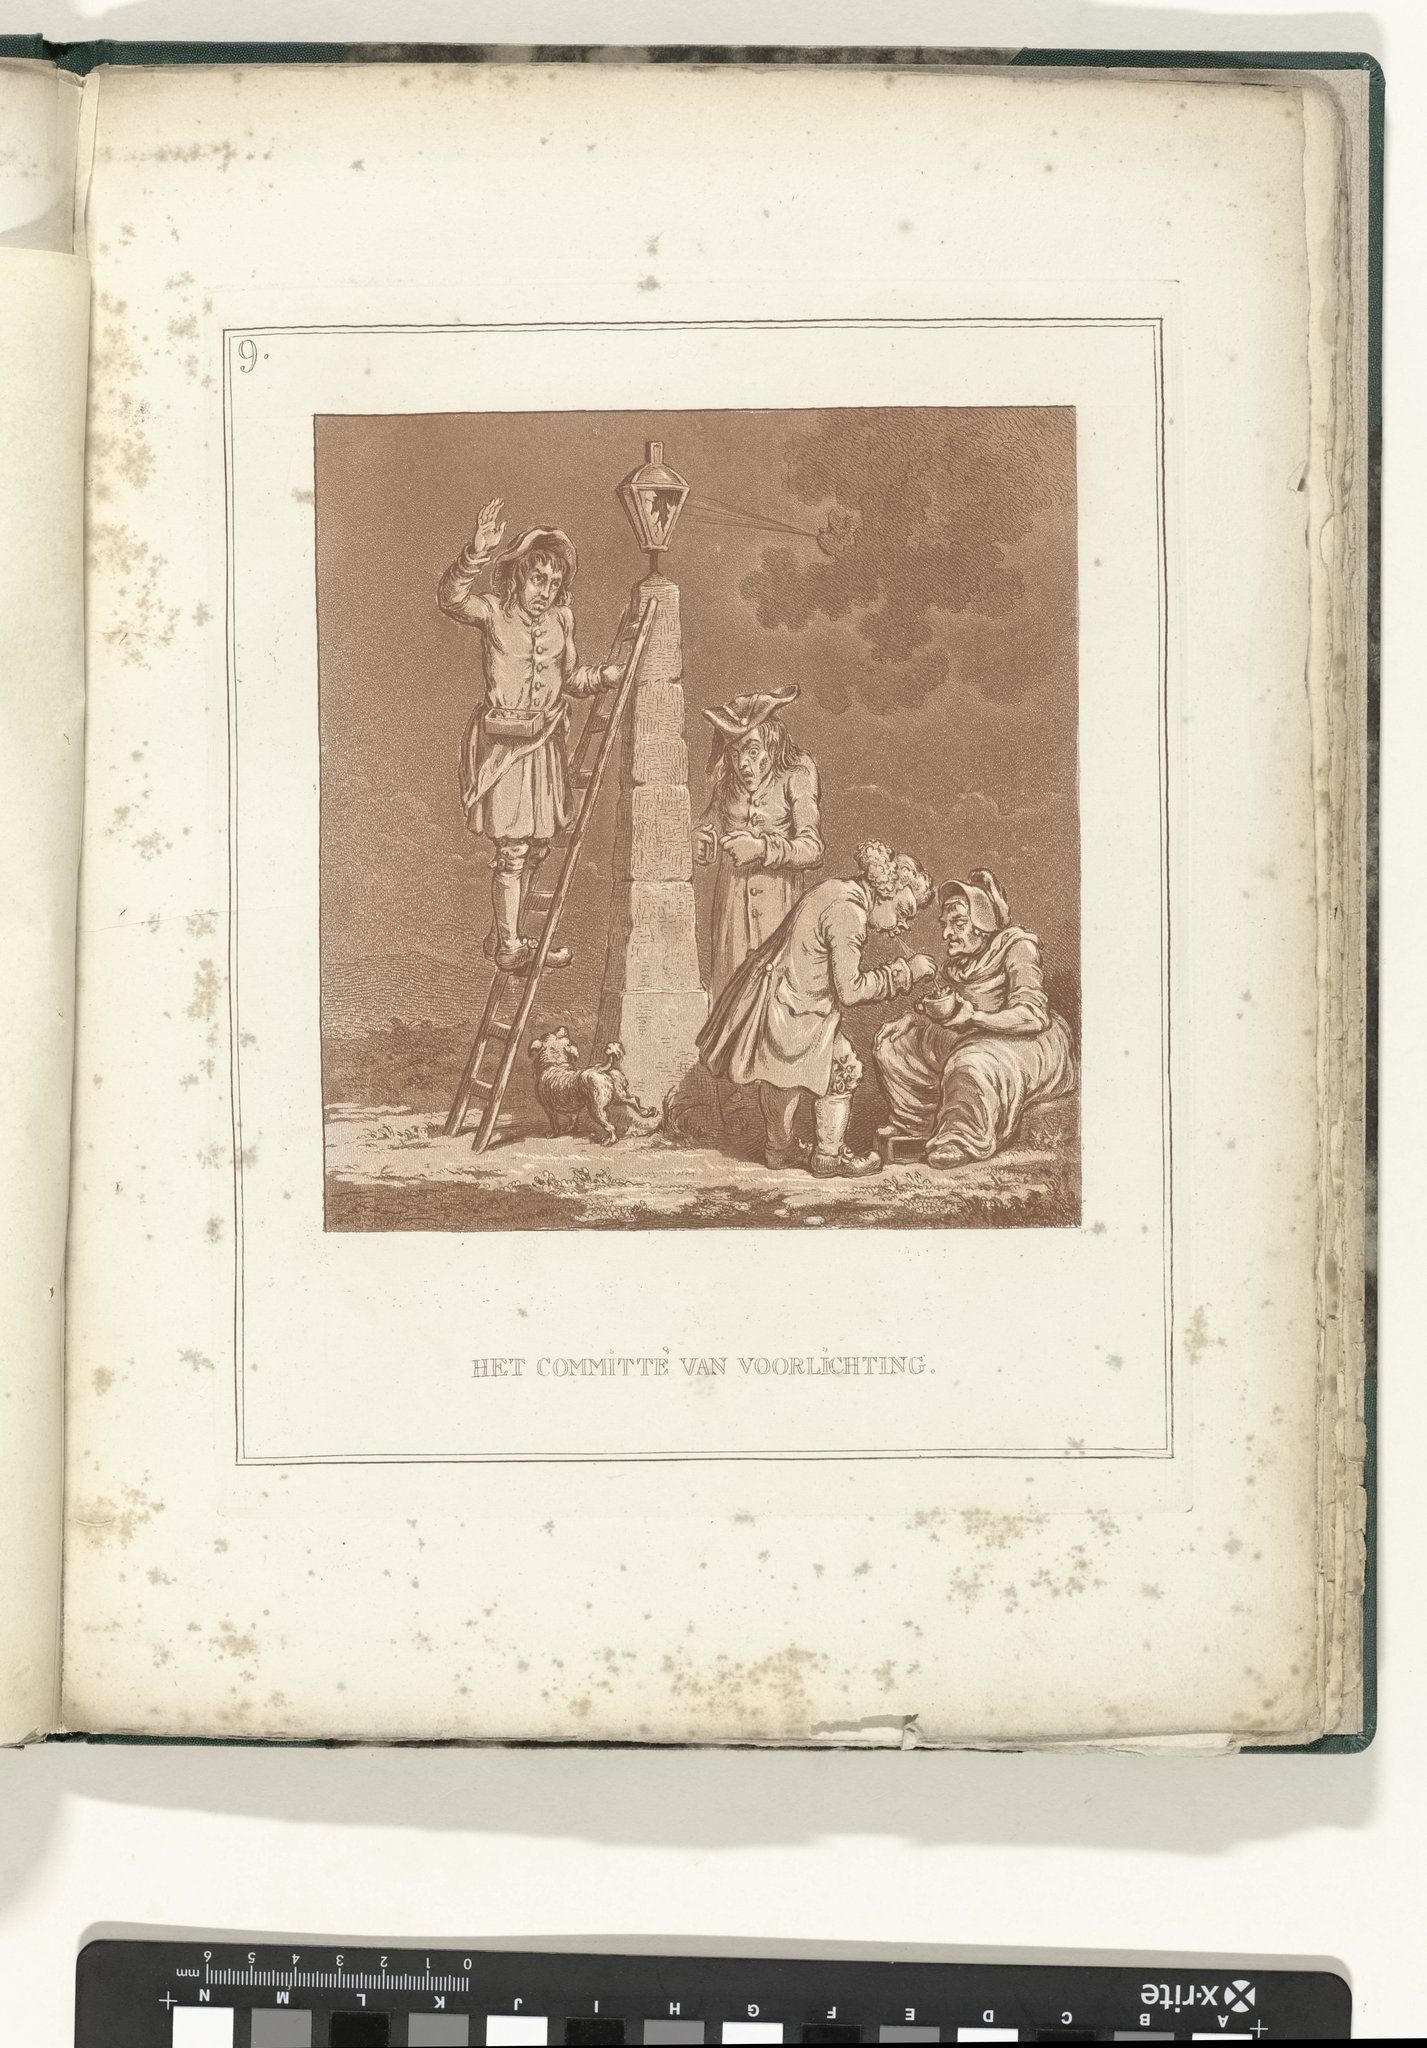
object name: print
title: Het Committé van Voorlichting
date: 1795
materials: paper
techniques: aquatint, etching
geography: london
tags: lantern (+ kindling a light; lit, burning light, lamp, candle)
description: Onderdeel van een in boekvorm uitgegeven serie van twintig spotprenten op de Provisionele Representanten van het Volk van Holland en de Bataafse Republiek in het algemeen in het jaar 1795. De serietitel 'Hollandia Regenerata' staat vermeld op de titelprent. Elke prent gevolgd door een tekstblad met een Bijbelcitaat in het Nederlands, een verklaring in het Frans en het Bijbelcitaat in het Engels. Waarschijnlijk uitgegeven in Londen door William Humphrey in 1795.